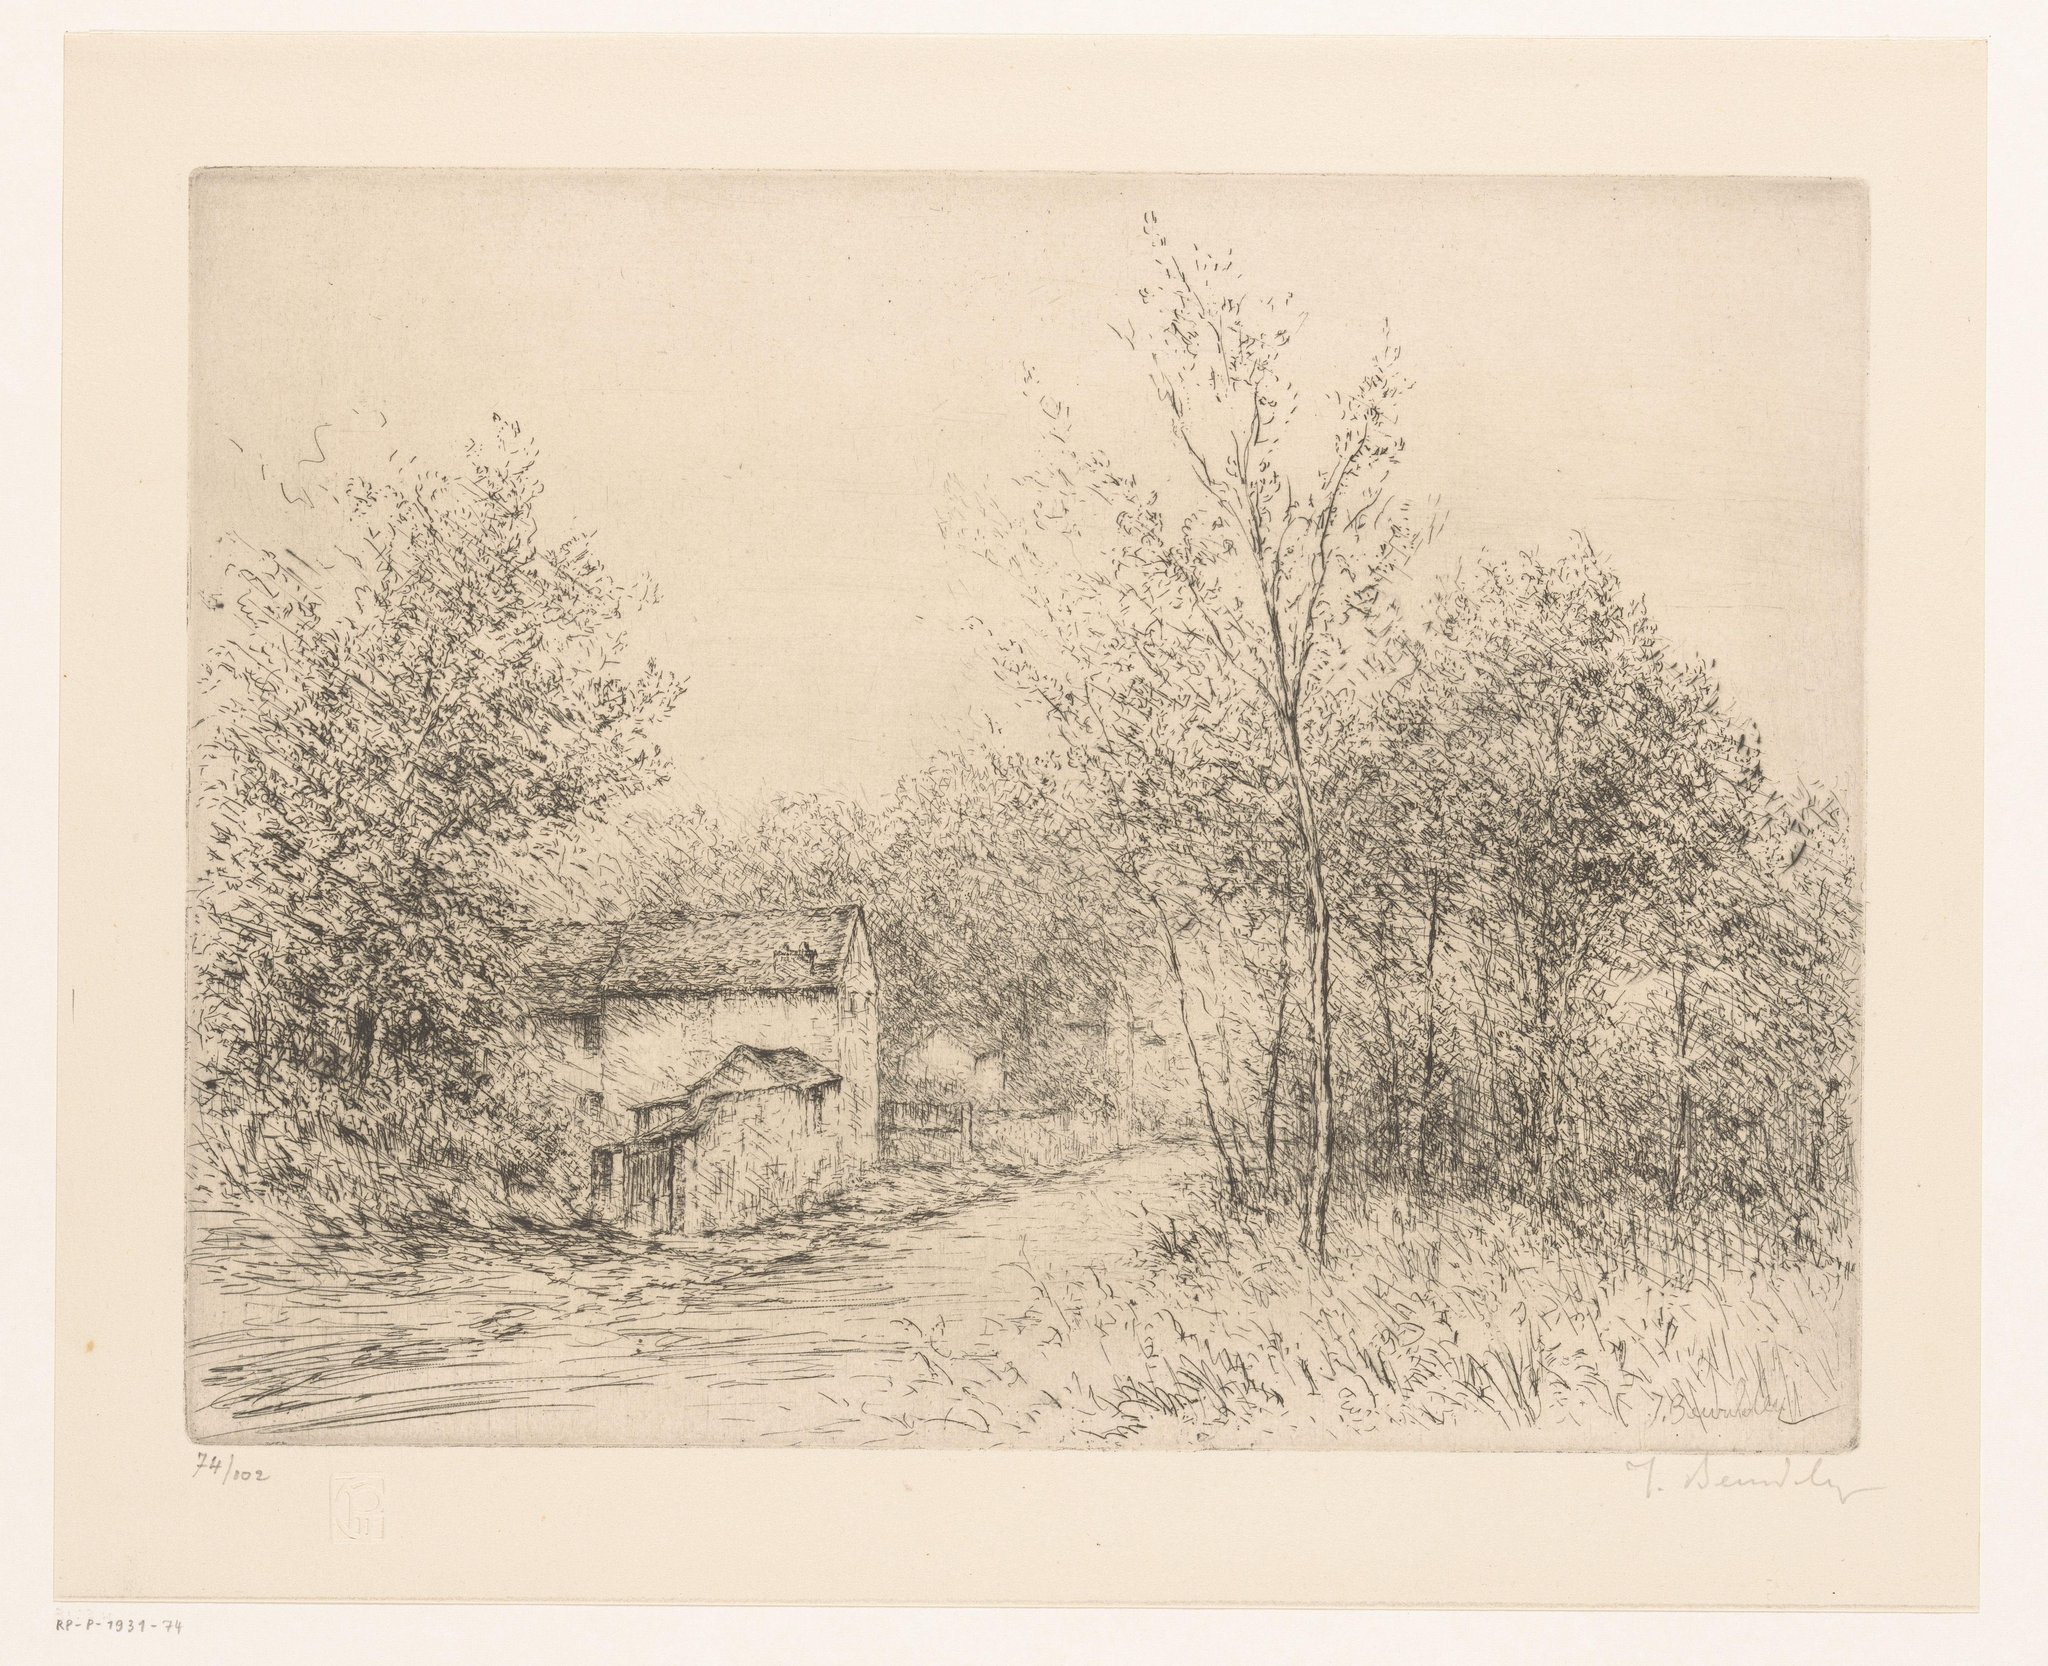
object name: print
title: Rustieke straat met bomen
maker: jacques beurdeley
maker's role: print maker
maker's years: 1874-1954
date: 1884-1931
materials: paper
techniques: drypoint, etching, intaglio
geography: france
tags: rural housing, e.g. country-house, villa, cottage, road, path, bush, shrubs ~ forest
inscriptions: watermark, check stamp: Lugt 1195a, collector's mark: Lugt 2228